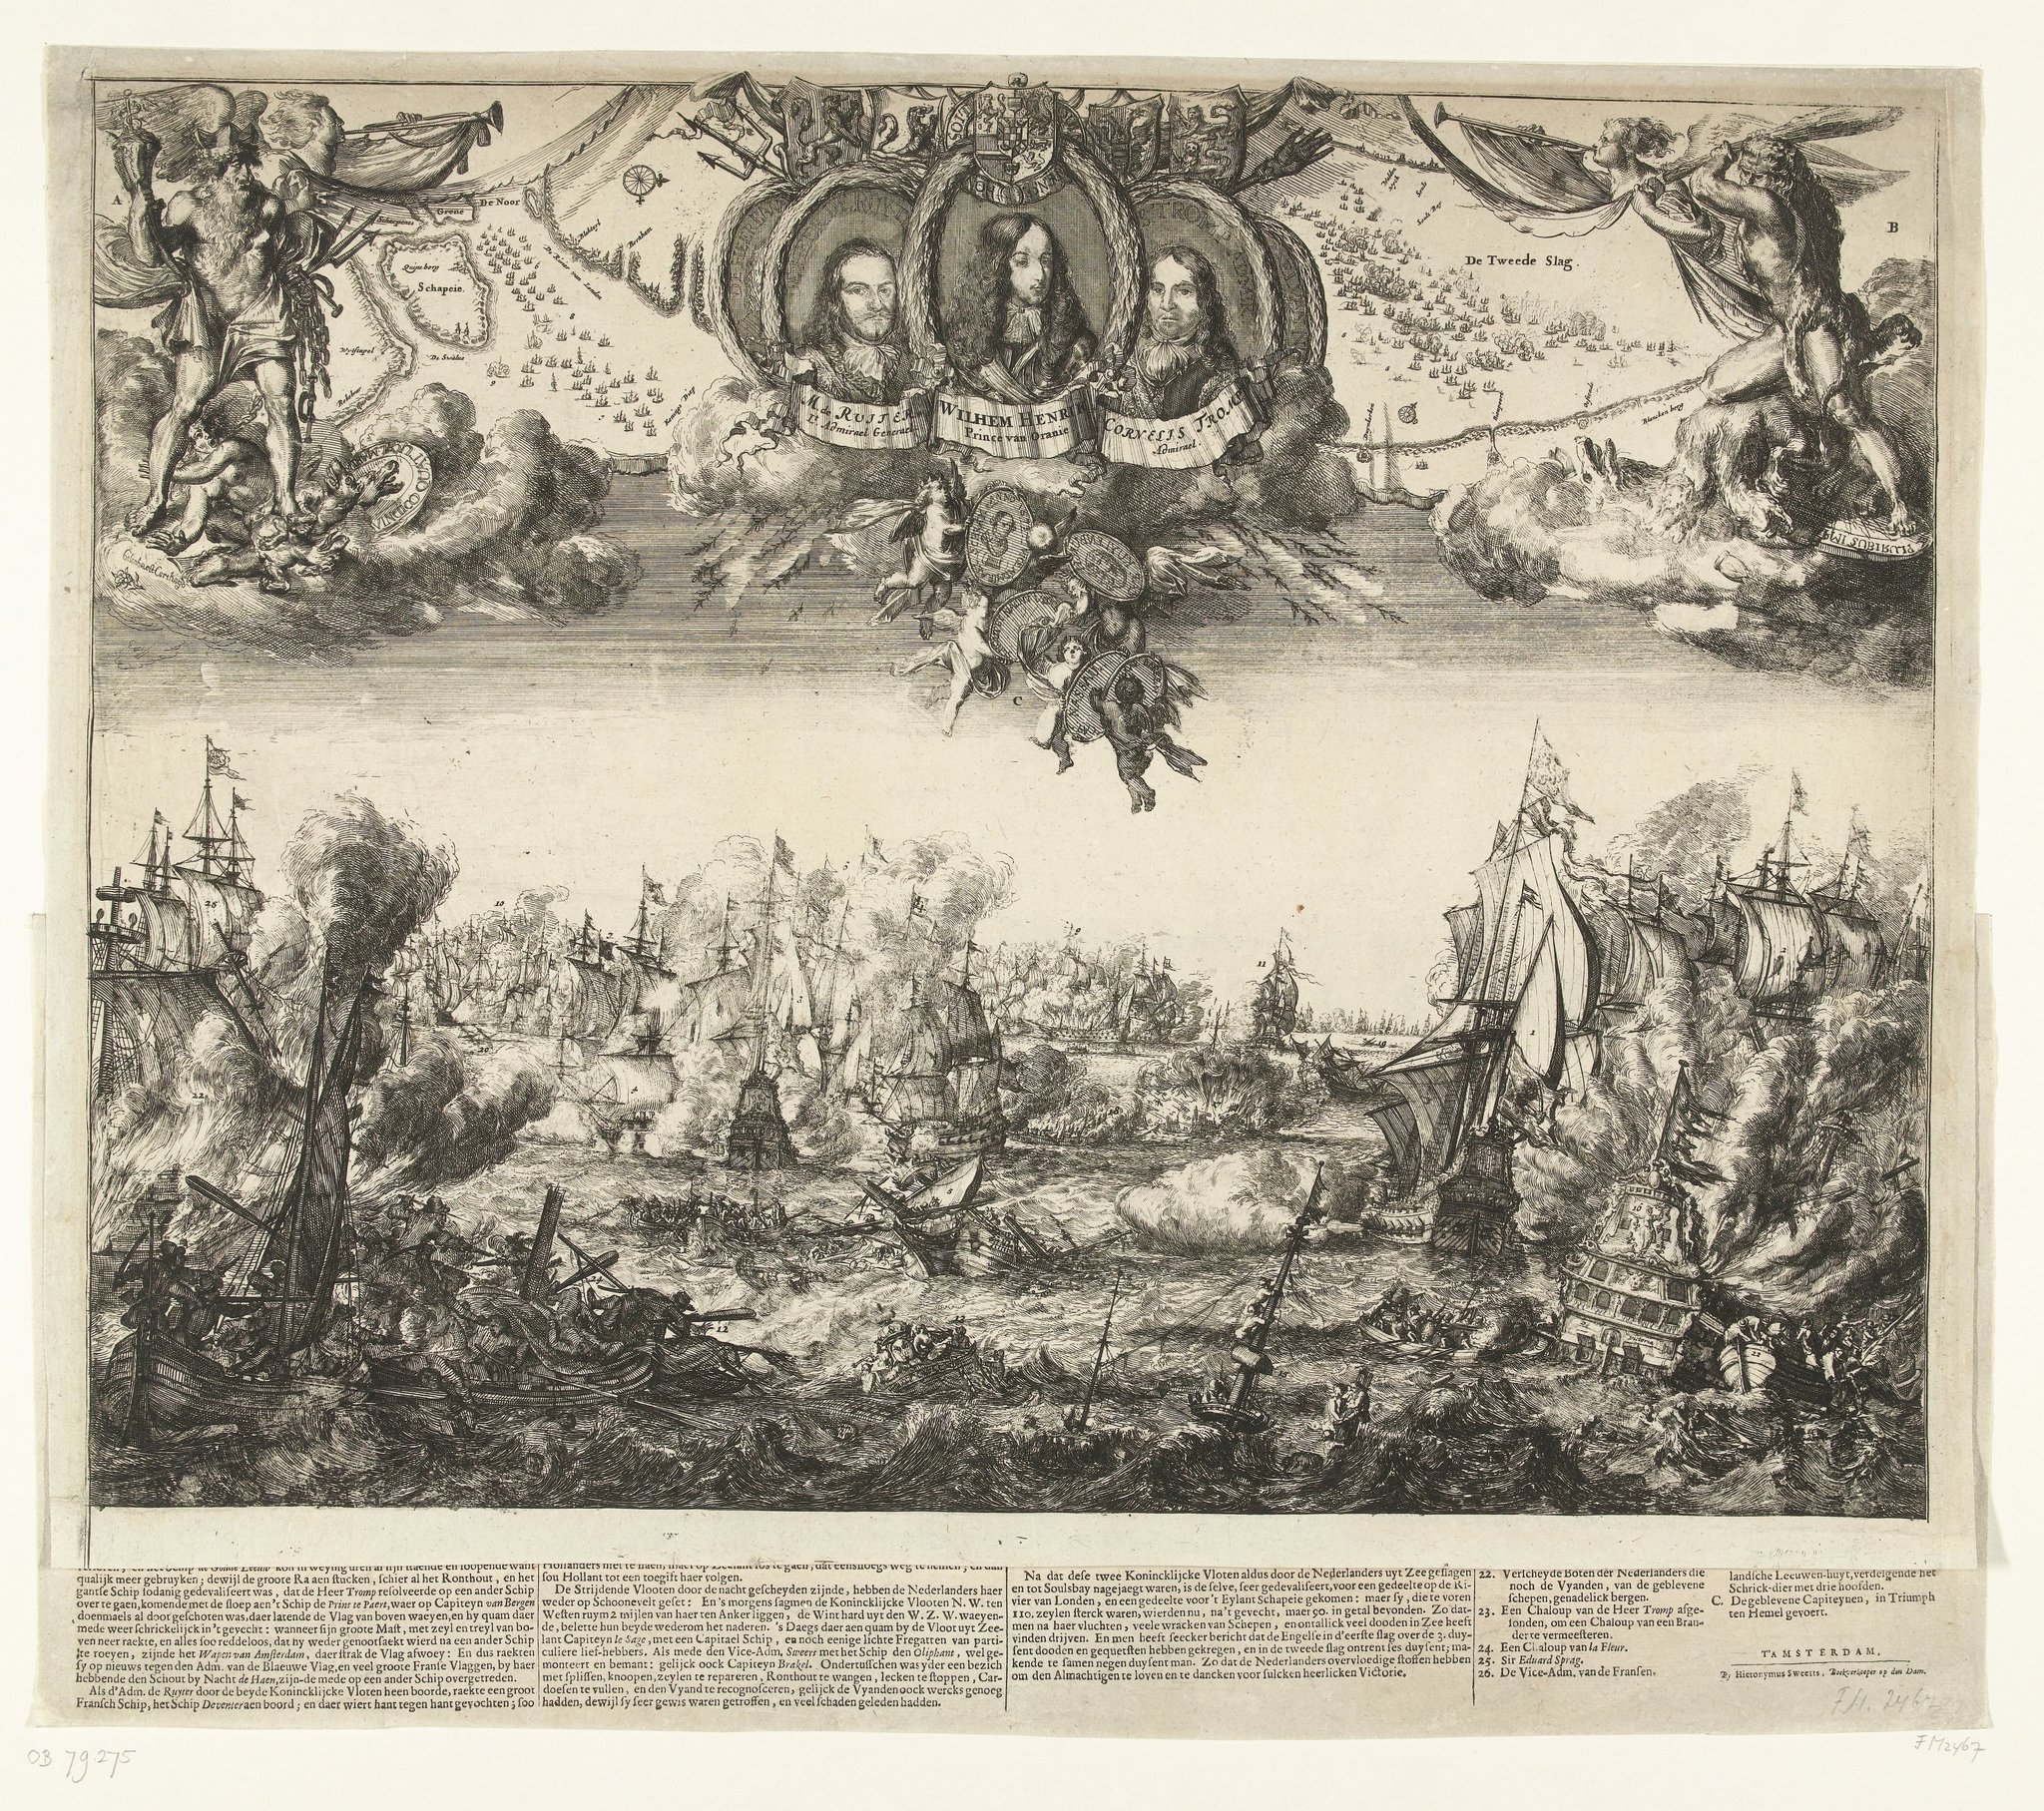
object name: print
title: De twee zeeslagen op Schoonevelt, 1673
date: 1673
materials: paper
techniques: engraving, etching, letterpress printing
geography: northern netherlands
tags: flushing, michiel adriaenszoon de ruyter, rotterdam, amsterdam, cornelis tromp, william iii (prince of orange and king of england, scotland, and ireland), battle (+ naval force), first battle of schooneveld, second battle of schooneveld, raid on the medway, battle of solebay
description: De twee zeeslagen voor de Zeeuwse kust op de vlakte van Schoonevelt op 7 juni en 14 juni 1673. Grote voorstelling van de slagen tussen de vloot van de Republiek onder Michiel Adriaenszoon de Ruyter en de gecombineerde Engels-Franse vloot onder Prins Rupert en graaf Jean d'Estrées. Bovenaan medaillons met portretten van Willem III, Michiel Adriaenszoon de Ruyter en Cornelis Tromp. Hiernaast kleine scènes met de tocht naar Chatham in 1667 en de slag bij Solebay in 1672. Hierbij allegorische figuren van de strijdbare Zeevaart en van Hercules. Bij de prent een tekstblad met de titel en een beschrijving van de gebeurtenissen en legenda's 1-26, 1-9 en A-C in 4 kolommen in het Nederlands.